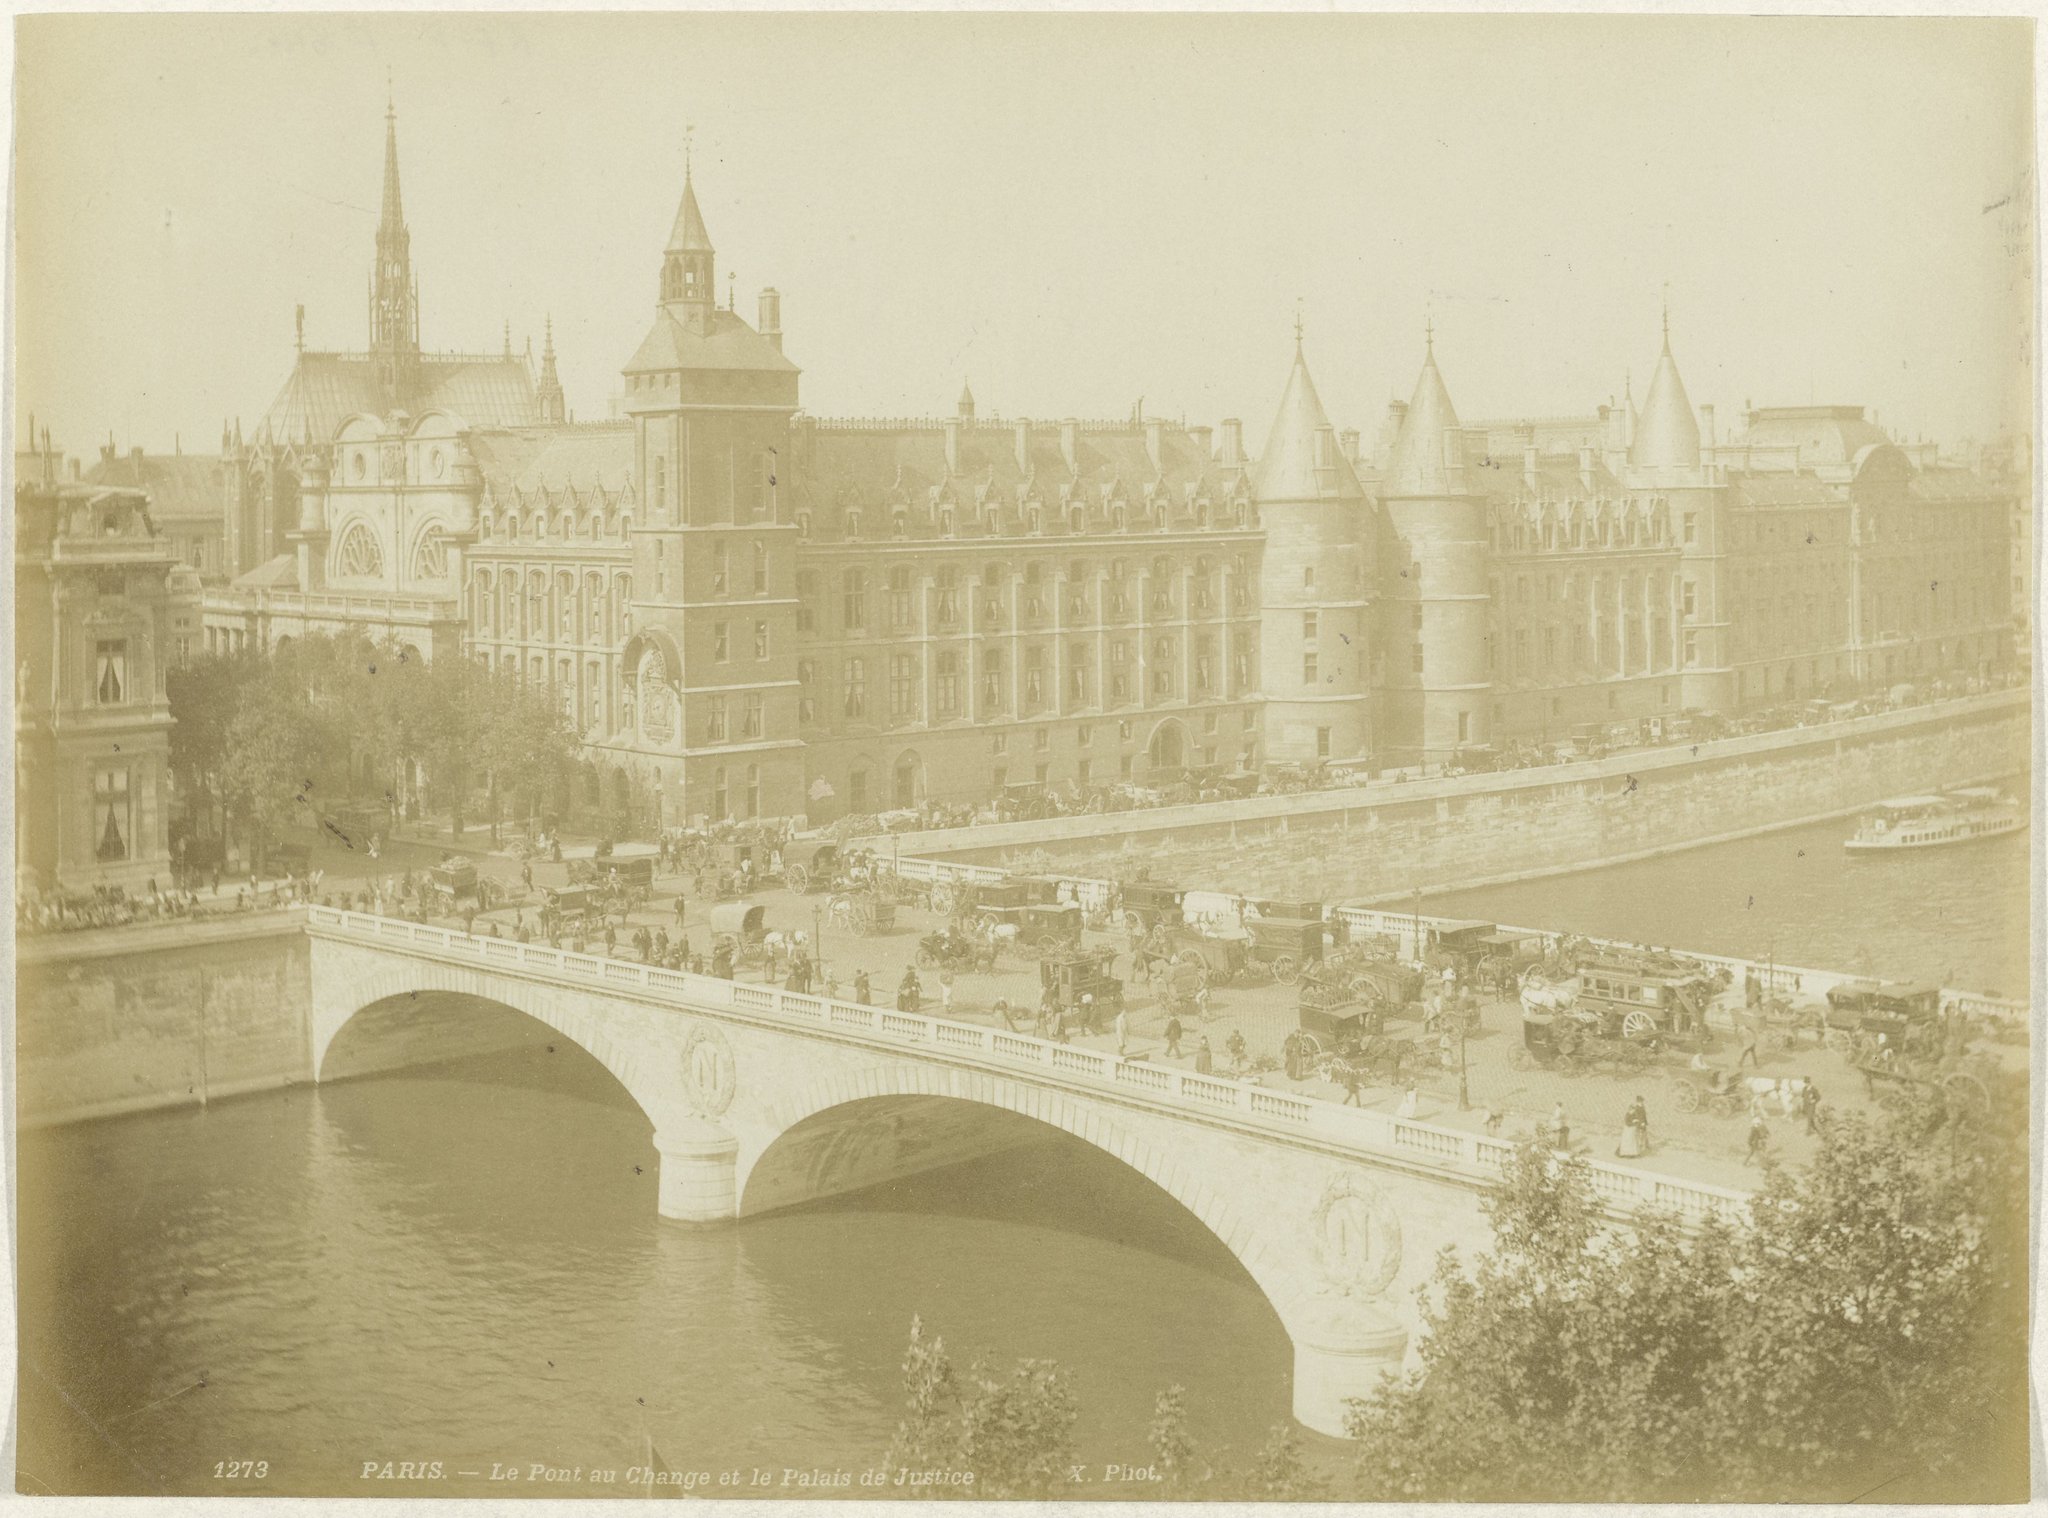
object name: photograph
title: Gezicht op de Seine, de Pont au Change en het Paleis van Justitie, Parijs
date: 1887-1900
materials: paper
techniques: albumen print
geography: paris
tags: court building, river, bridge in city across river, canal, etc., paris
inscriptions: inscription: ‘1273/ Paris. - Le Pont au Change et le Palais de Justice X Phot.’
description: Tussen 1887 en ca. 1900 werkten Neurdein frères onder andere onder de naam 'X phot.'.